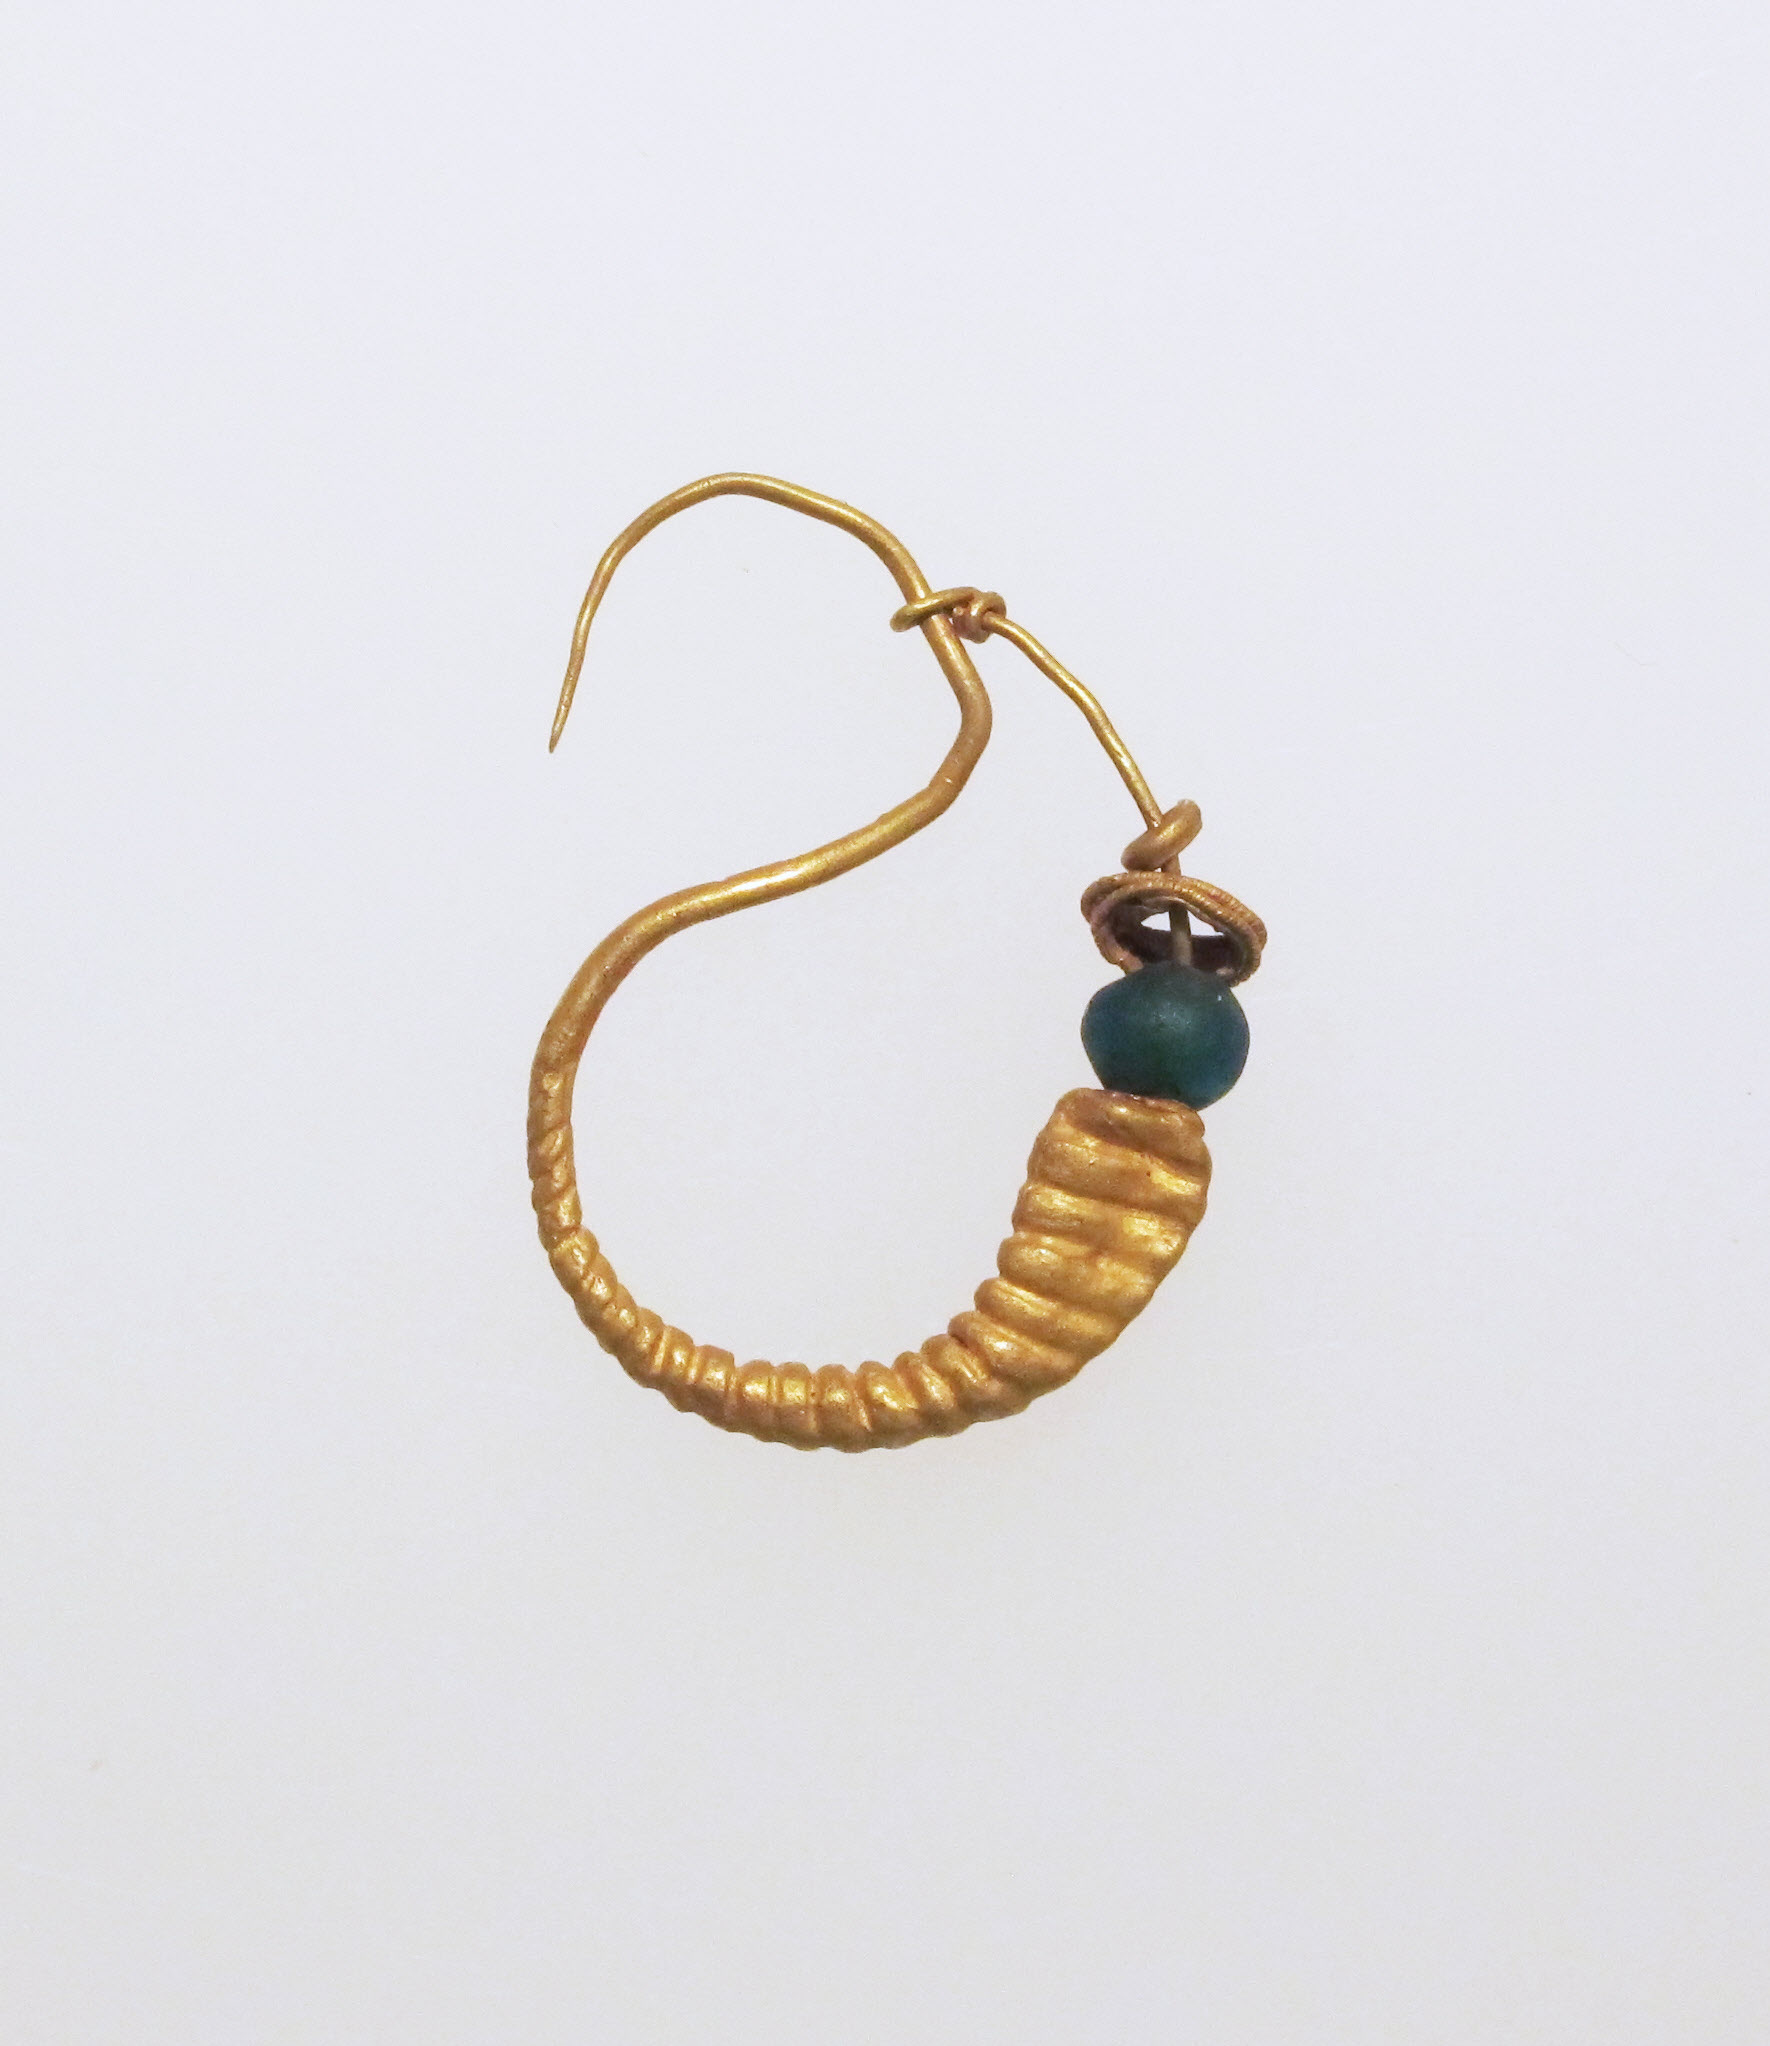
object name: earring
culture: etruscan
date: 900-100 BCE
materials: glass, gold